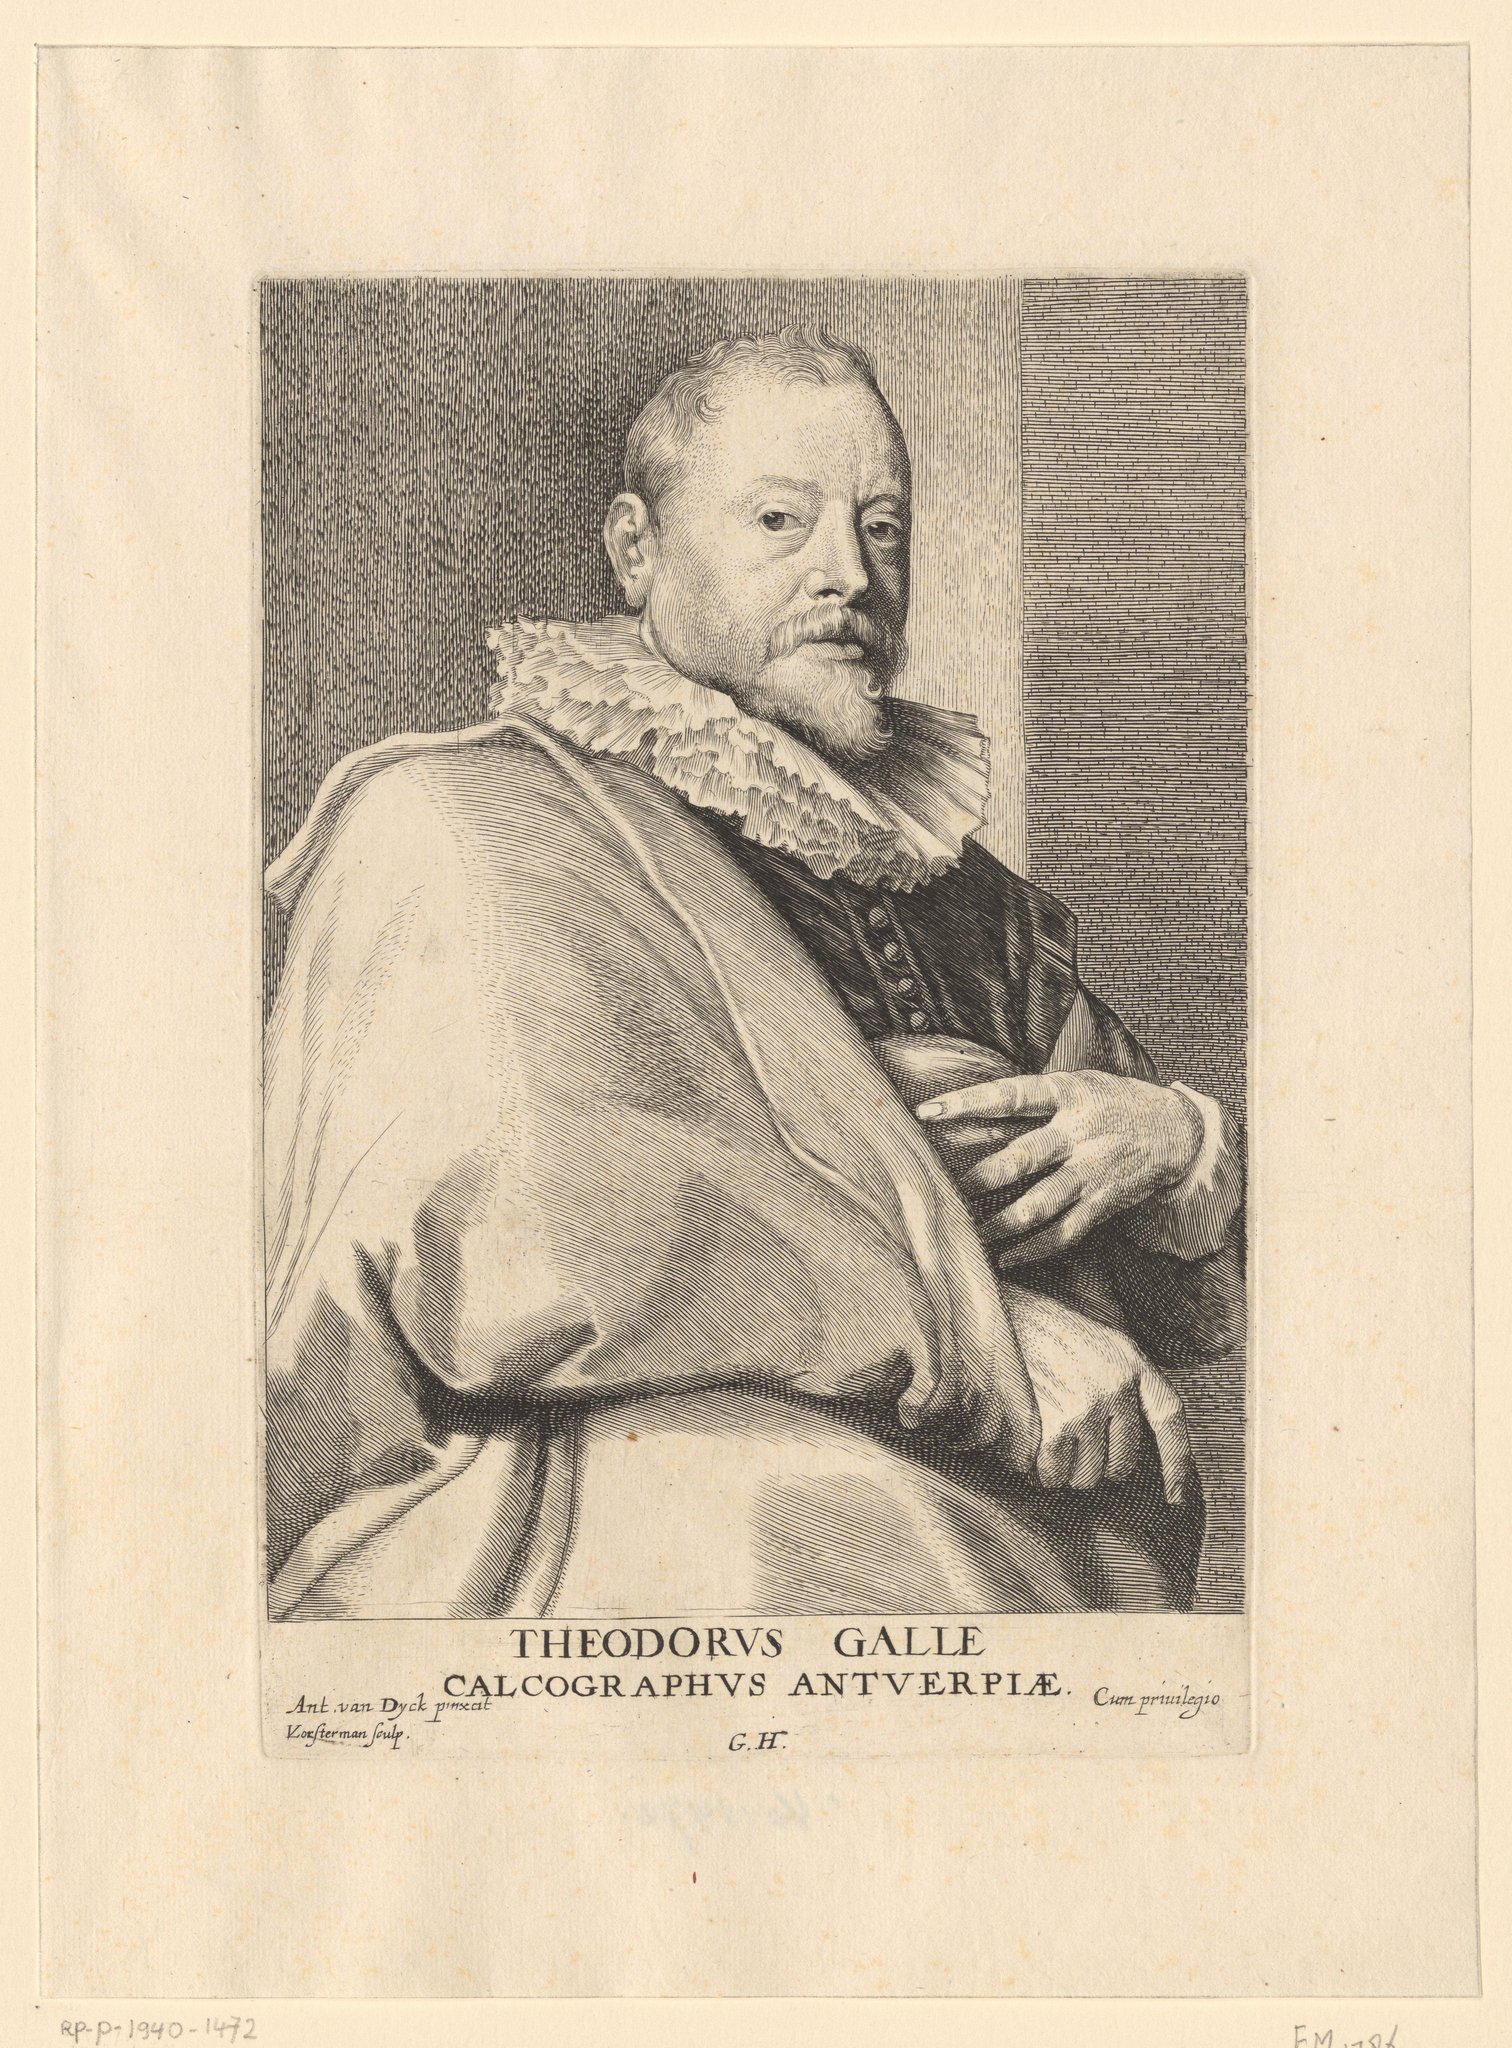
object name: print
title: Iconographie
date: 1630-1641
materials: paper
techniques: engraving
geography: antwerp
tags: antwerp, theodoor galle, historical persons, portrait, self-portrait of graphic artist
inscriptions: collector's mark: Lugt 2760, collector's mark: Lugt 2760, inscription: ‘W. 81 III’, collector's mark: Lugt 2166, collector's mark: Lugt 2228